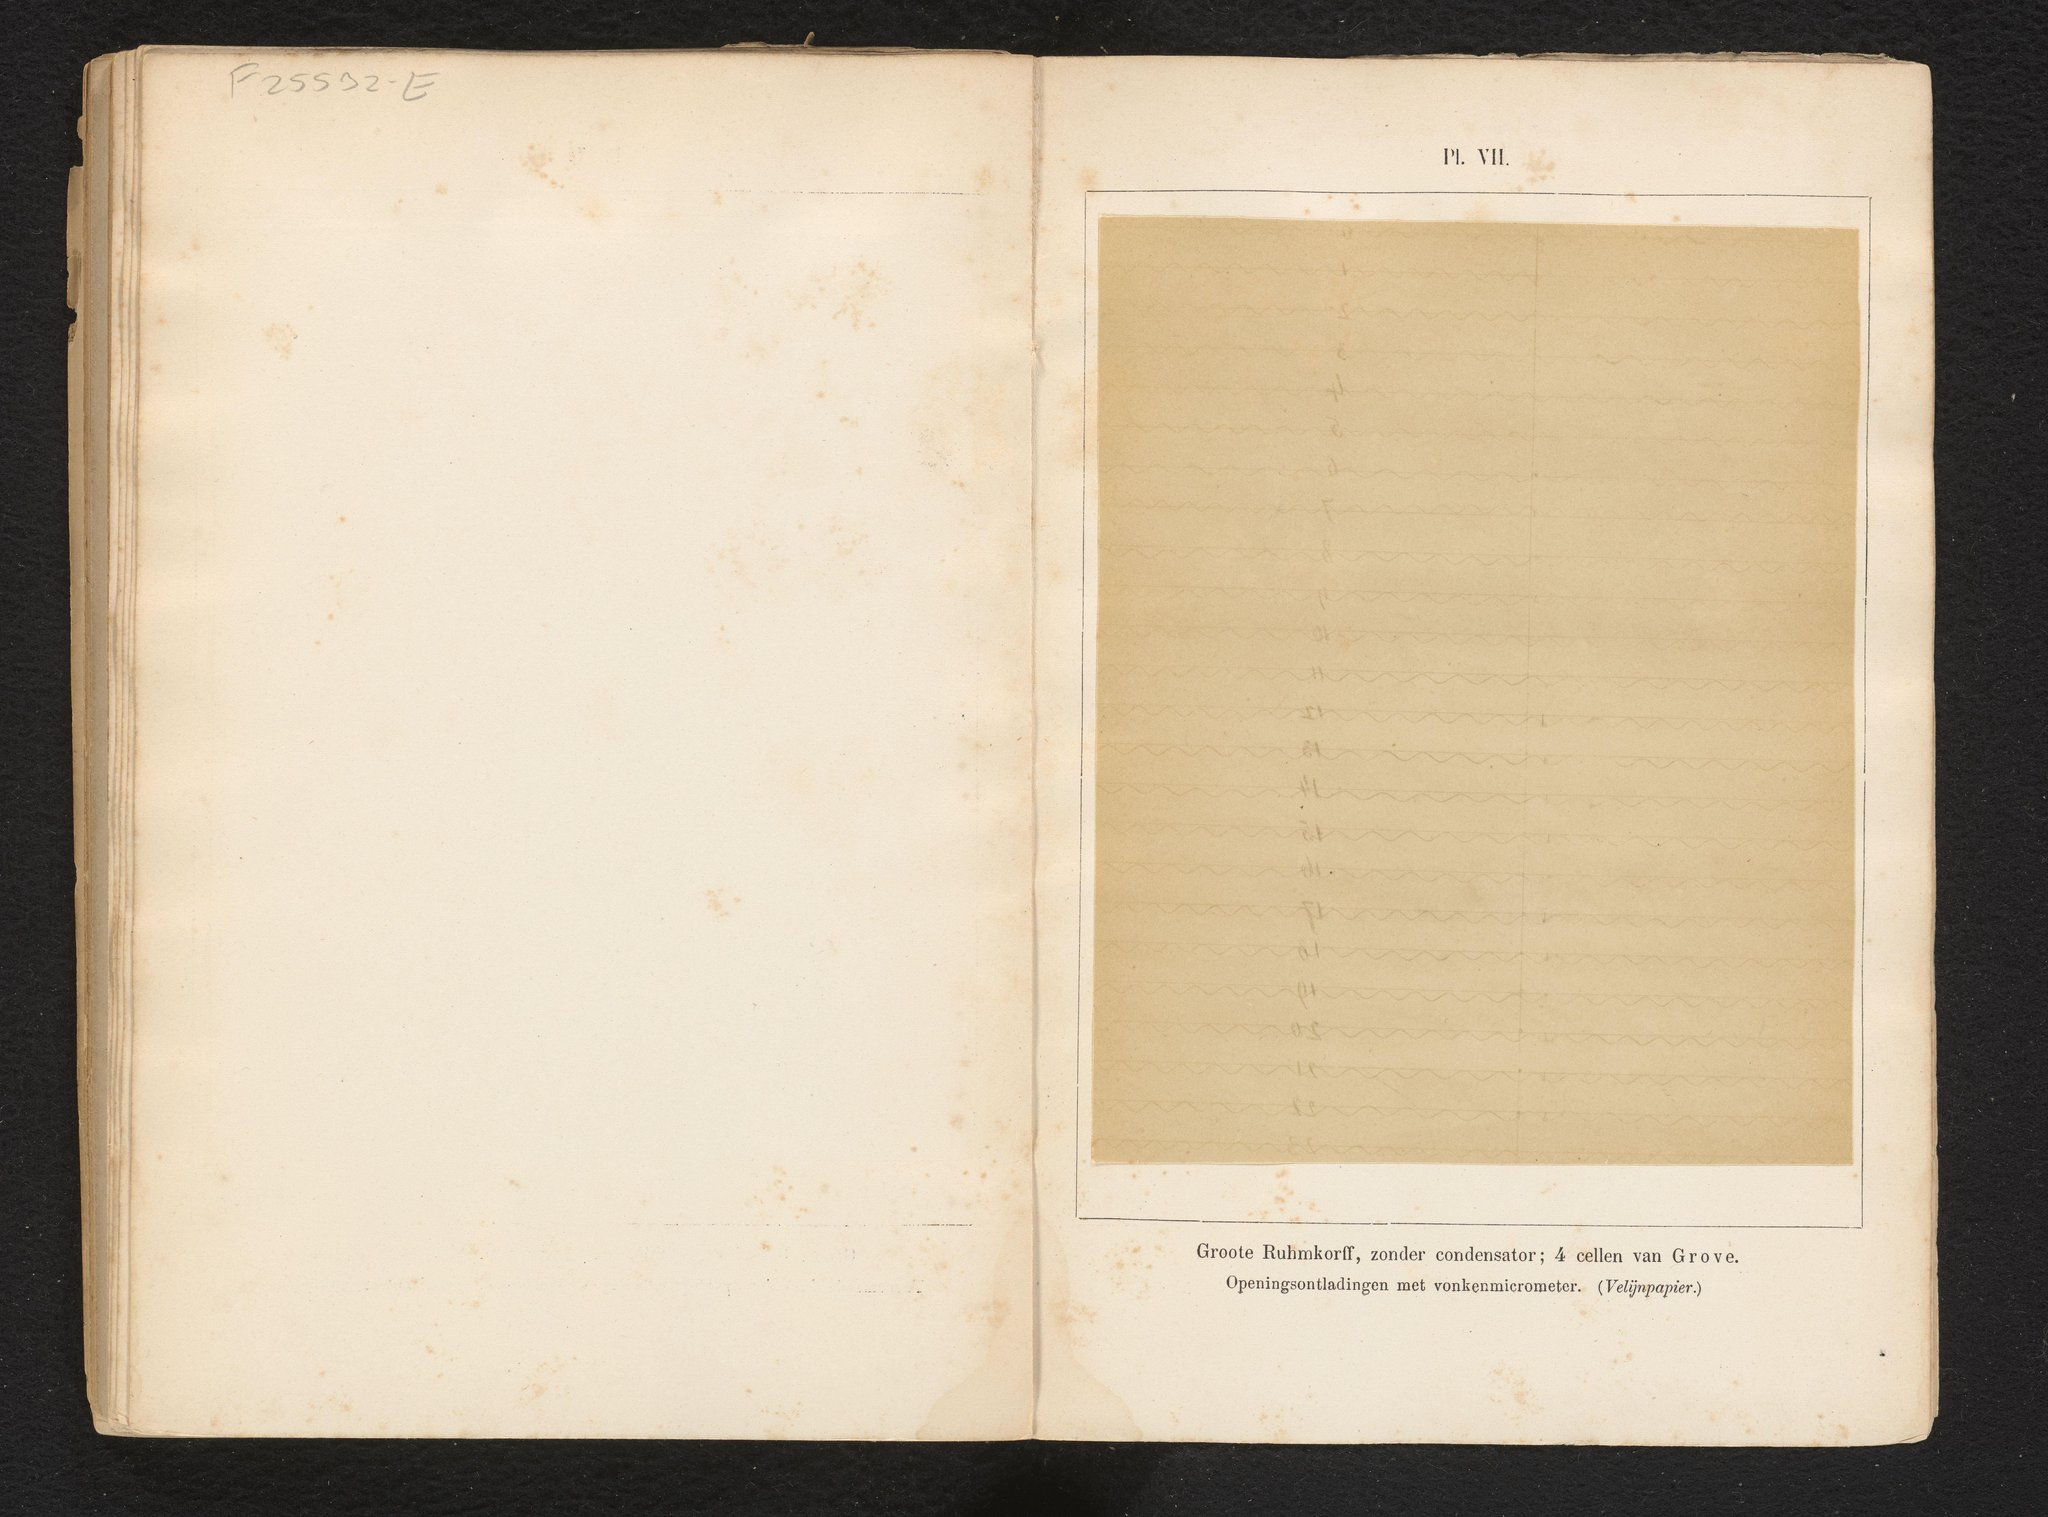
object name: page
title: Registratie van electriciteitsgolven opgewekt door een vonkinductor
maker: willem cornelis van dijk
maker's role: painter, print maker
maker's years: 1826-1881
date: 1865-1870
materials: paper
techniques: albumen print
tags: electrical phenomena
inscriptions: number: ‘Pl. VII.’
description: Foto op vijftiende ongenummerde pagina na pagina 95.